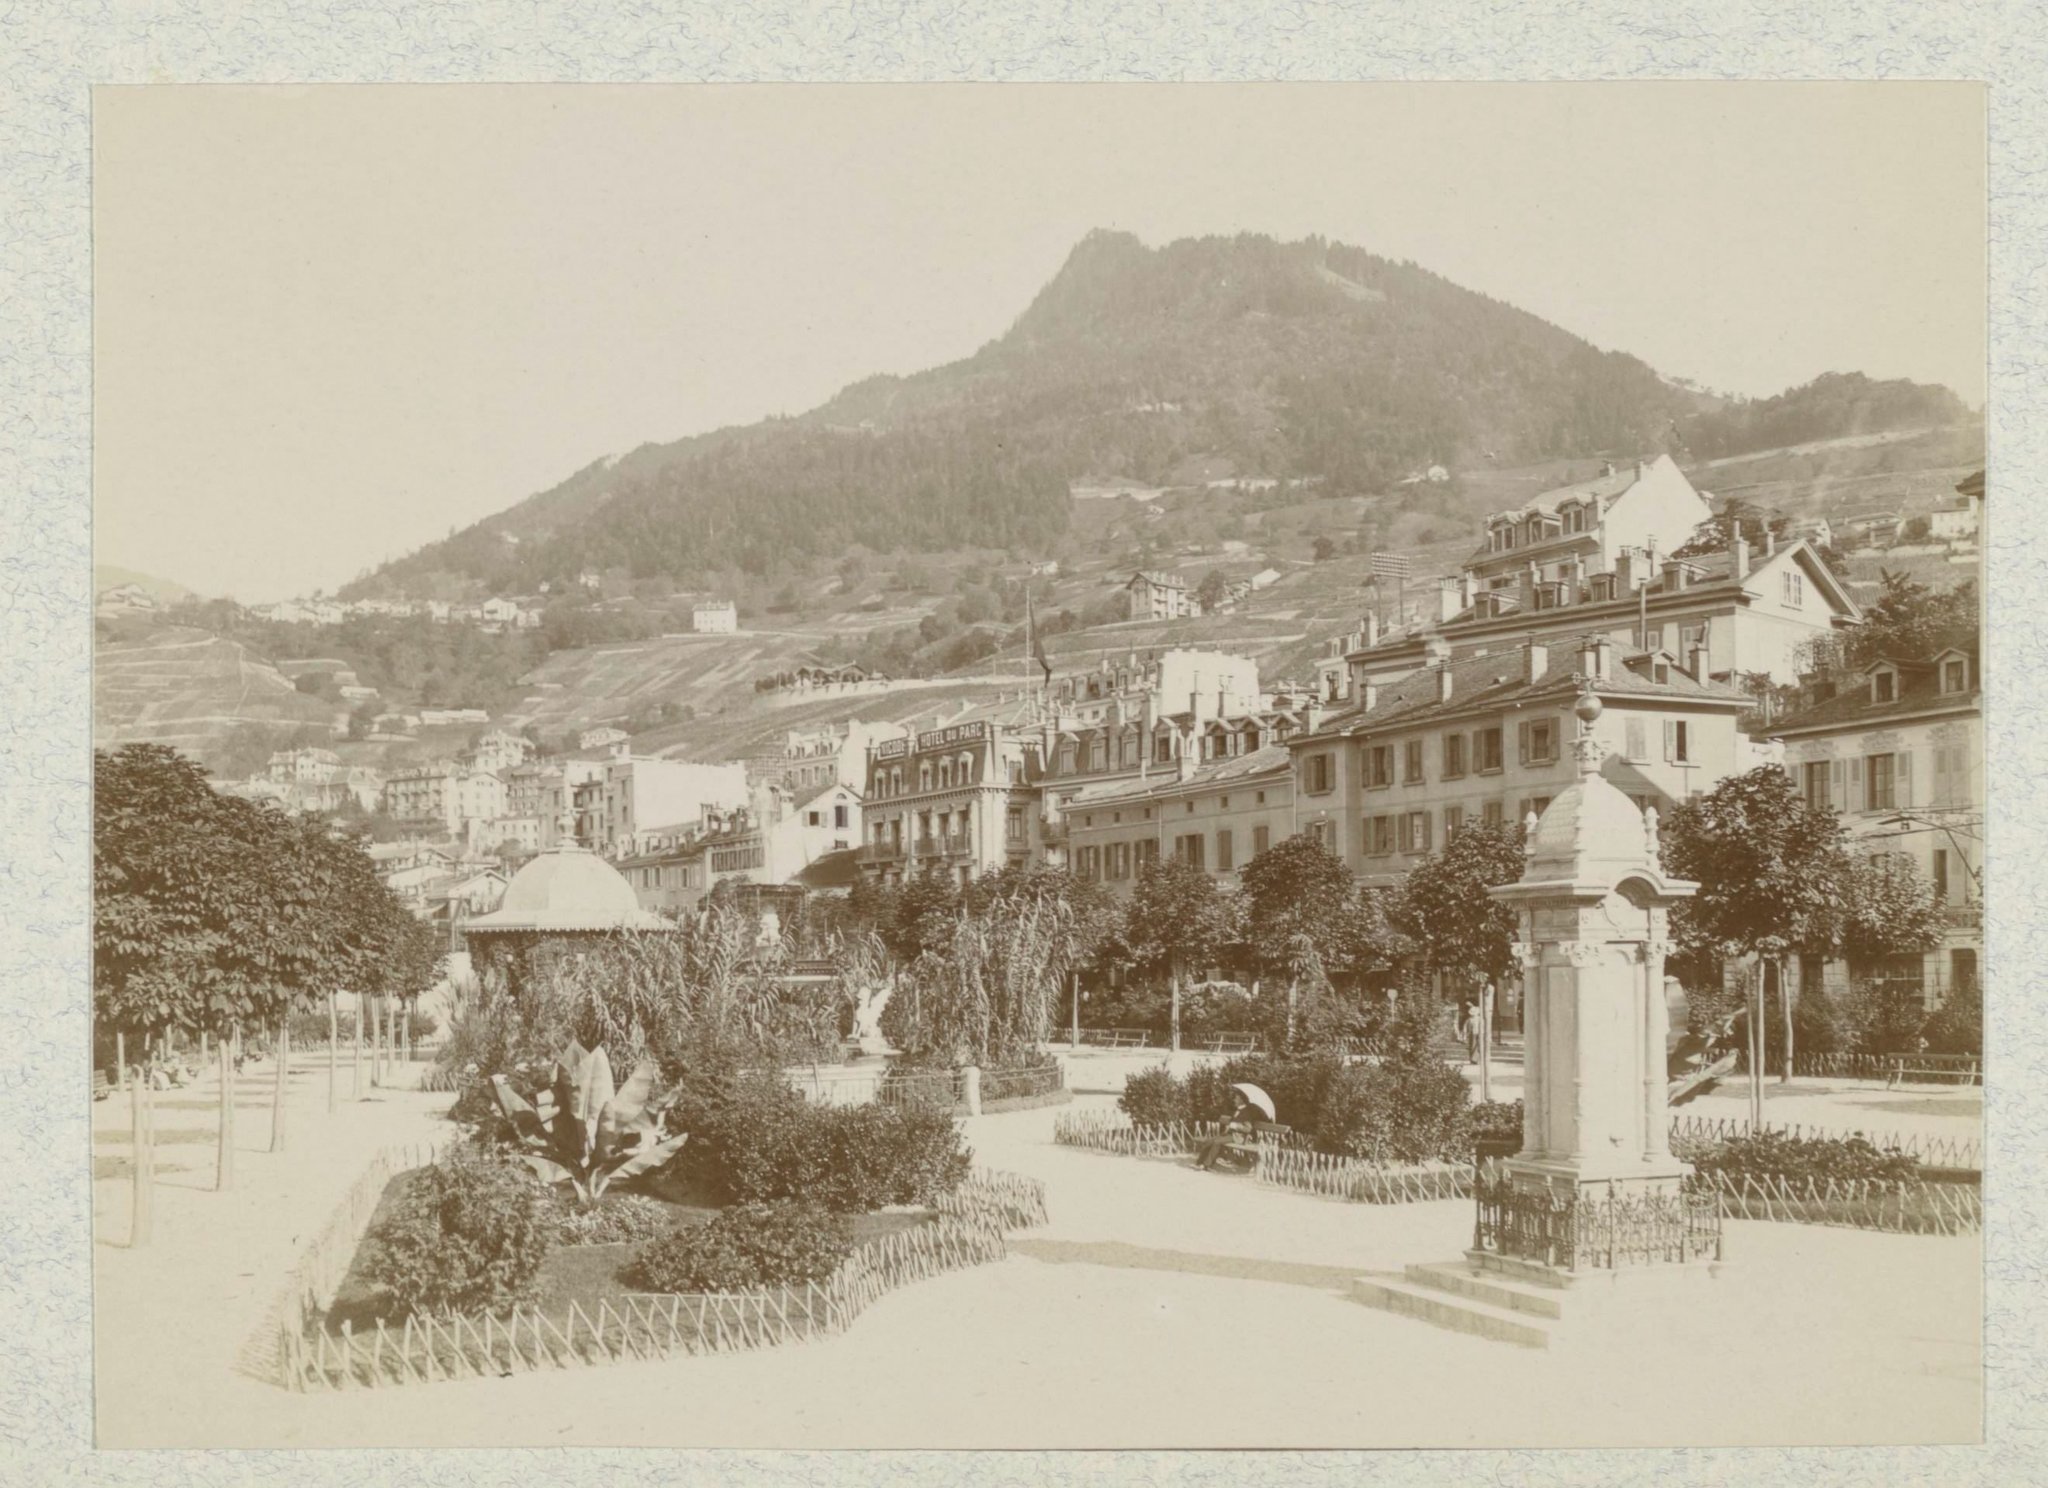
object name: photograph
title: Vakantie in Zwitserland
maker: andries augustus boom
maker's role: amateurfotograaf, handelaar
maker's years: 1878-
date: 1805-1899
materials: photographic support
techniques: photography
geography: switzerland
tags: andries augustus boom, switzerland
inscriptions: date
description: Vakantie in Zwitserland. Onderdeel van het fotoalbum van de familie Boom-Gonggrijp in Suriname en Curaçao.